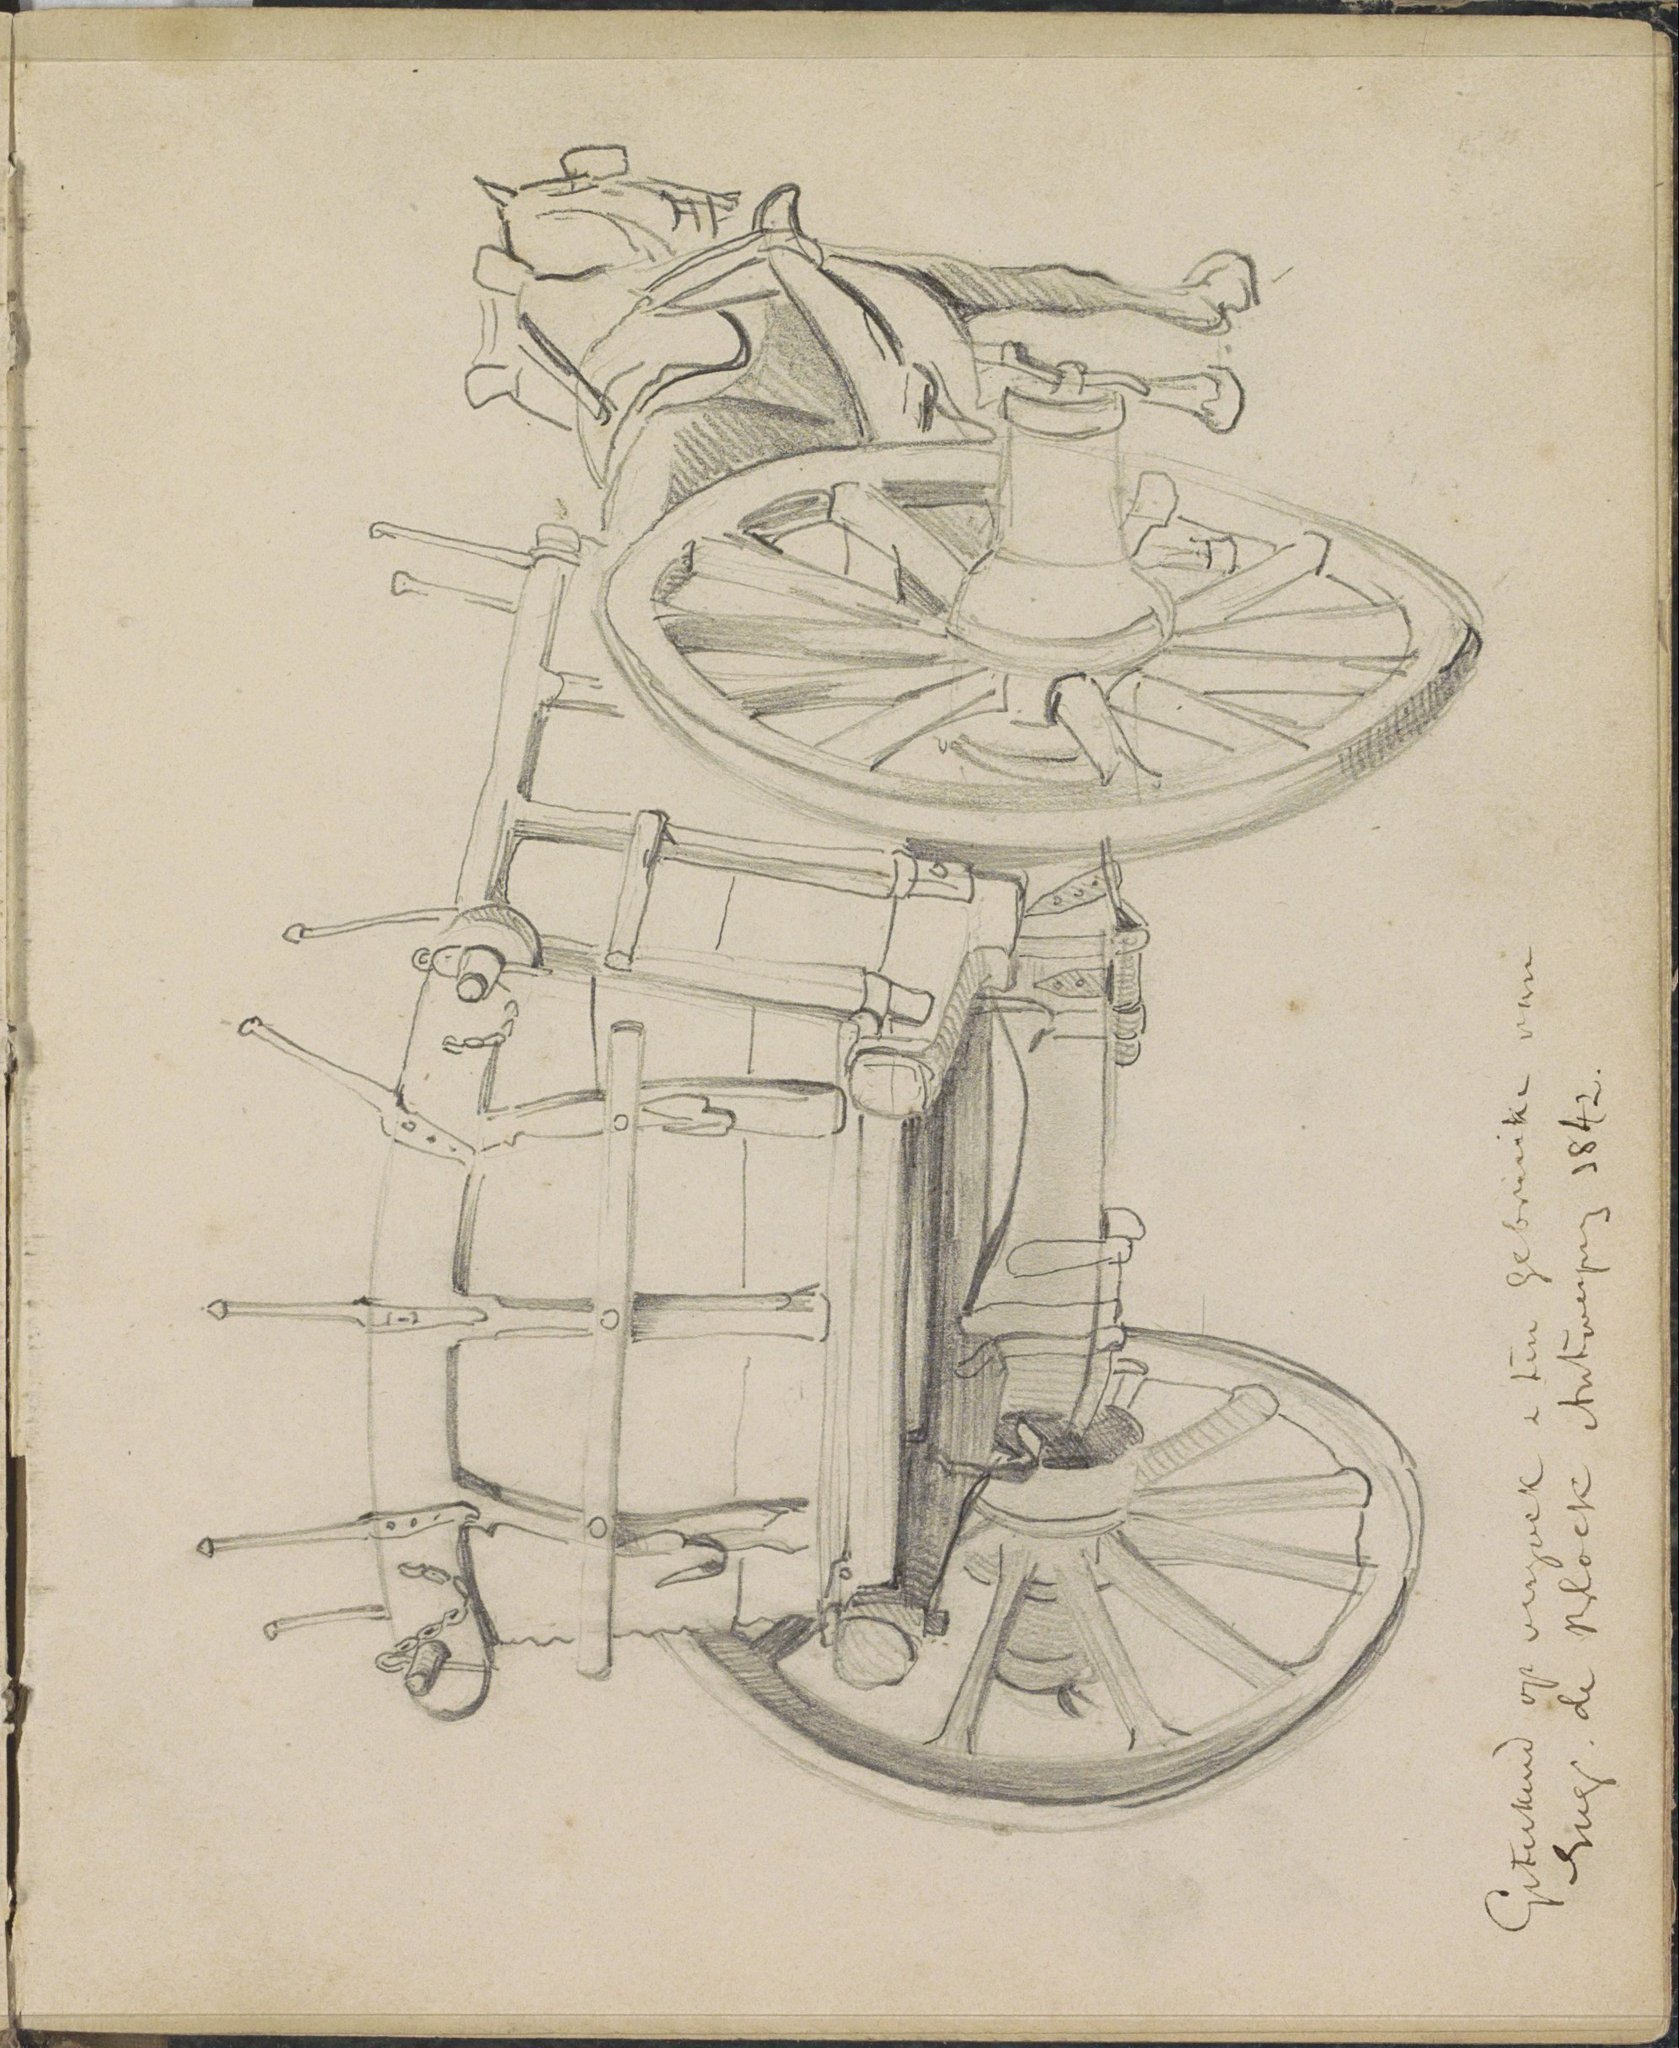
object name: sketchbook leaf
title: Paardenkar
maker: johannes tavenraat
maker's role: draughtsman, painter, print maker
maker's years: 1809-1881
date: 1842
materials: paper, pencil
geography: antwerp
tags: (farm) wagon, freight wagon, cart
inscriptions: date and inscription: ‘Geteekend op verzoek & ten gebruike van/ Sngr. de Block Antwerpen 1842.’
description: Blad 46 recto uit een schetsboek met 87 bladen.